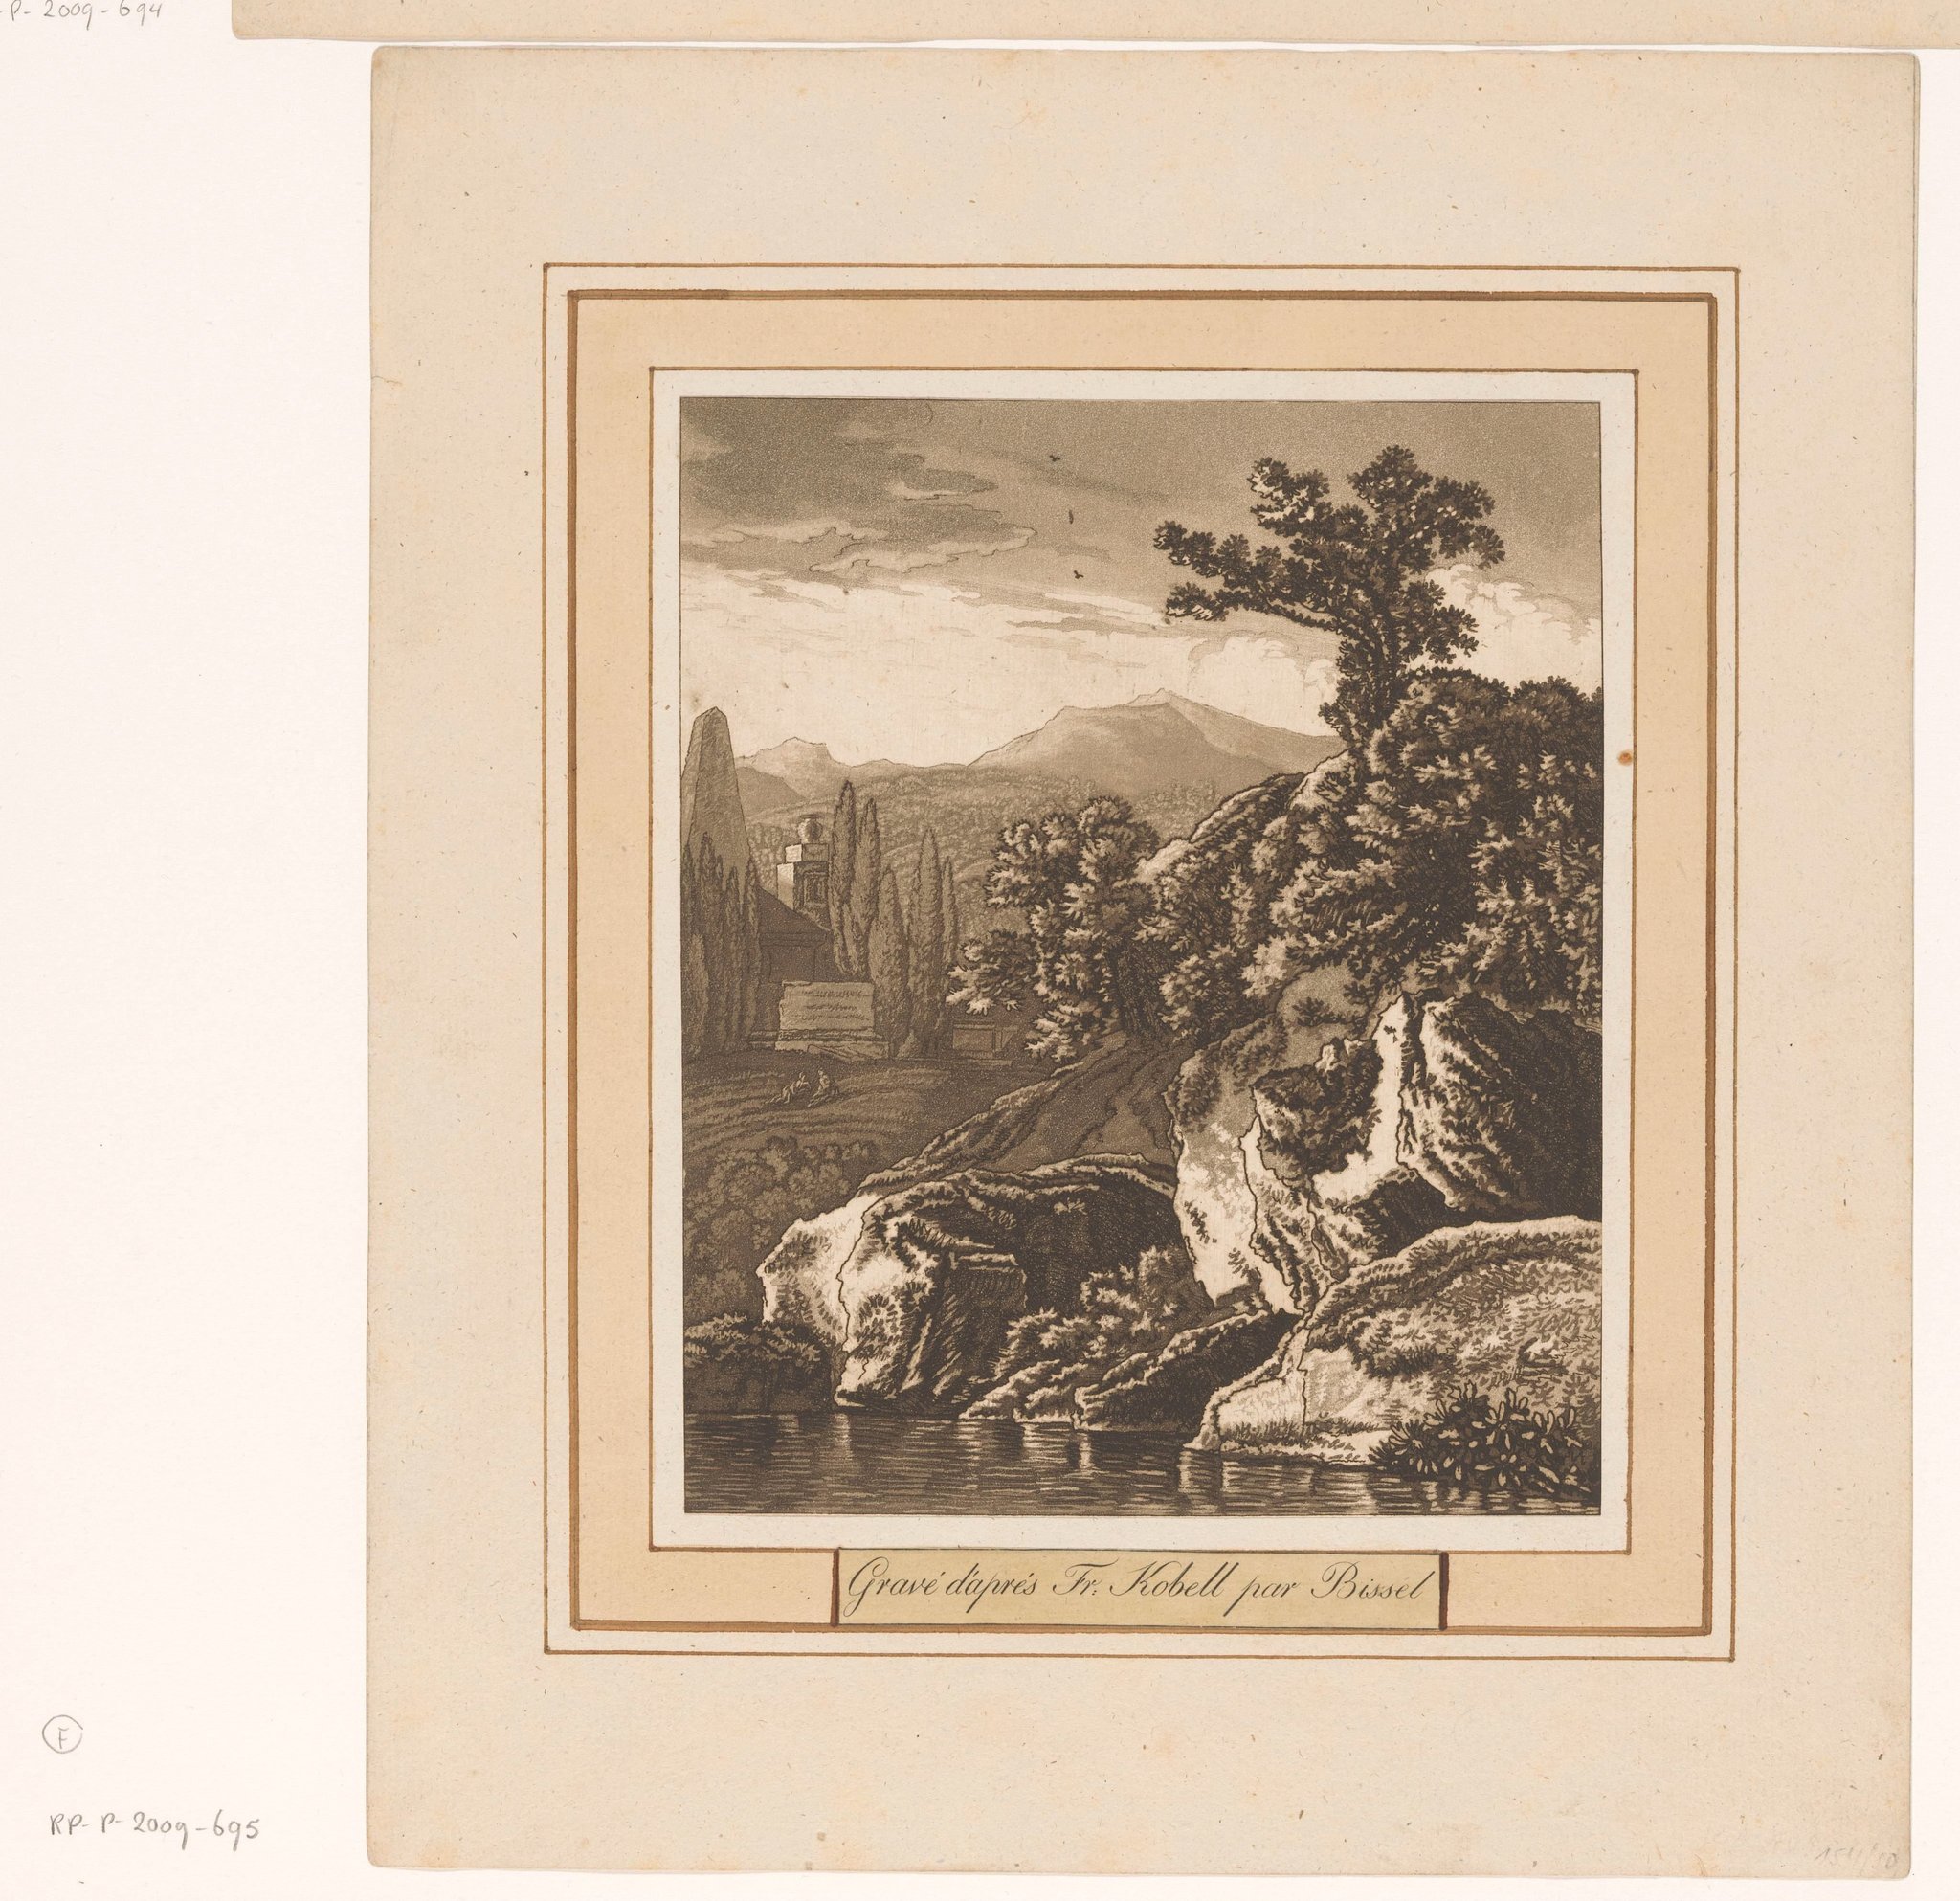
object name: print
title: Landschappen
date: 1791-1819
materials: paper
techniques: aquatint, etching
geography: mannheim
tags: grave-building, monumental tomb, rocks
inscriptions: collector's mark: Lugt 2760, collector's mark: Lugt 2228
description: Afkomstig uit een serie van twaalf landschappen naar ontwerp van Ferdinand, Franz en Wilhelm Kobell, in prent gebracht door verschillende prentmakers, uitgegeven door Domenico Artaria in Mannheim.